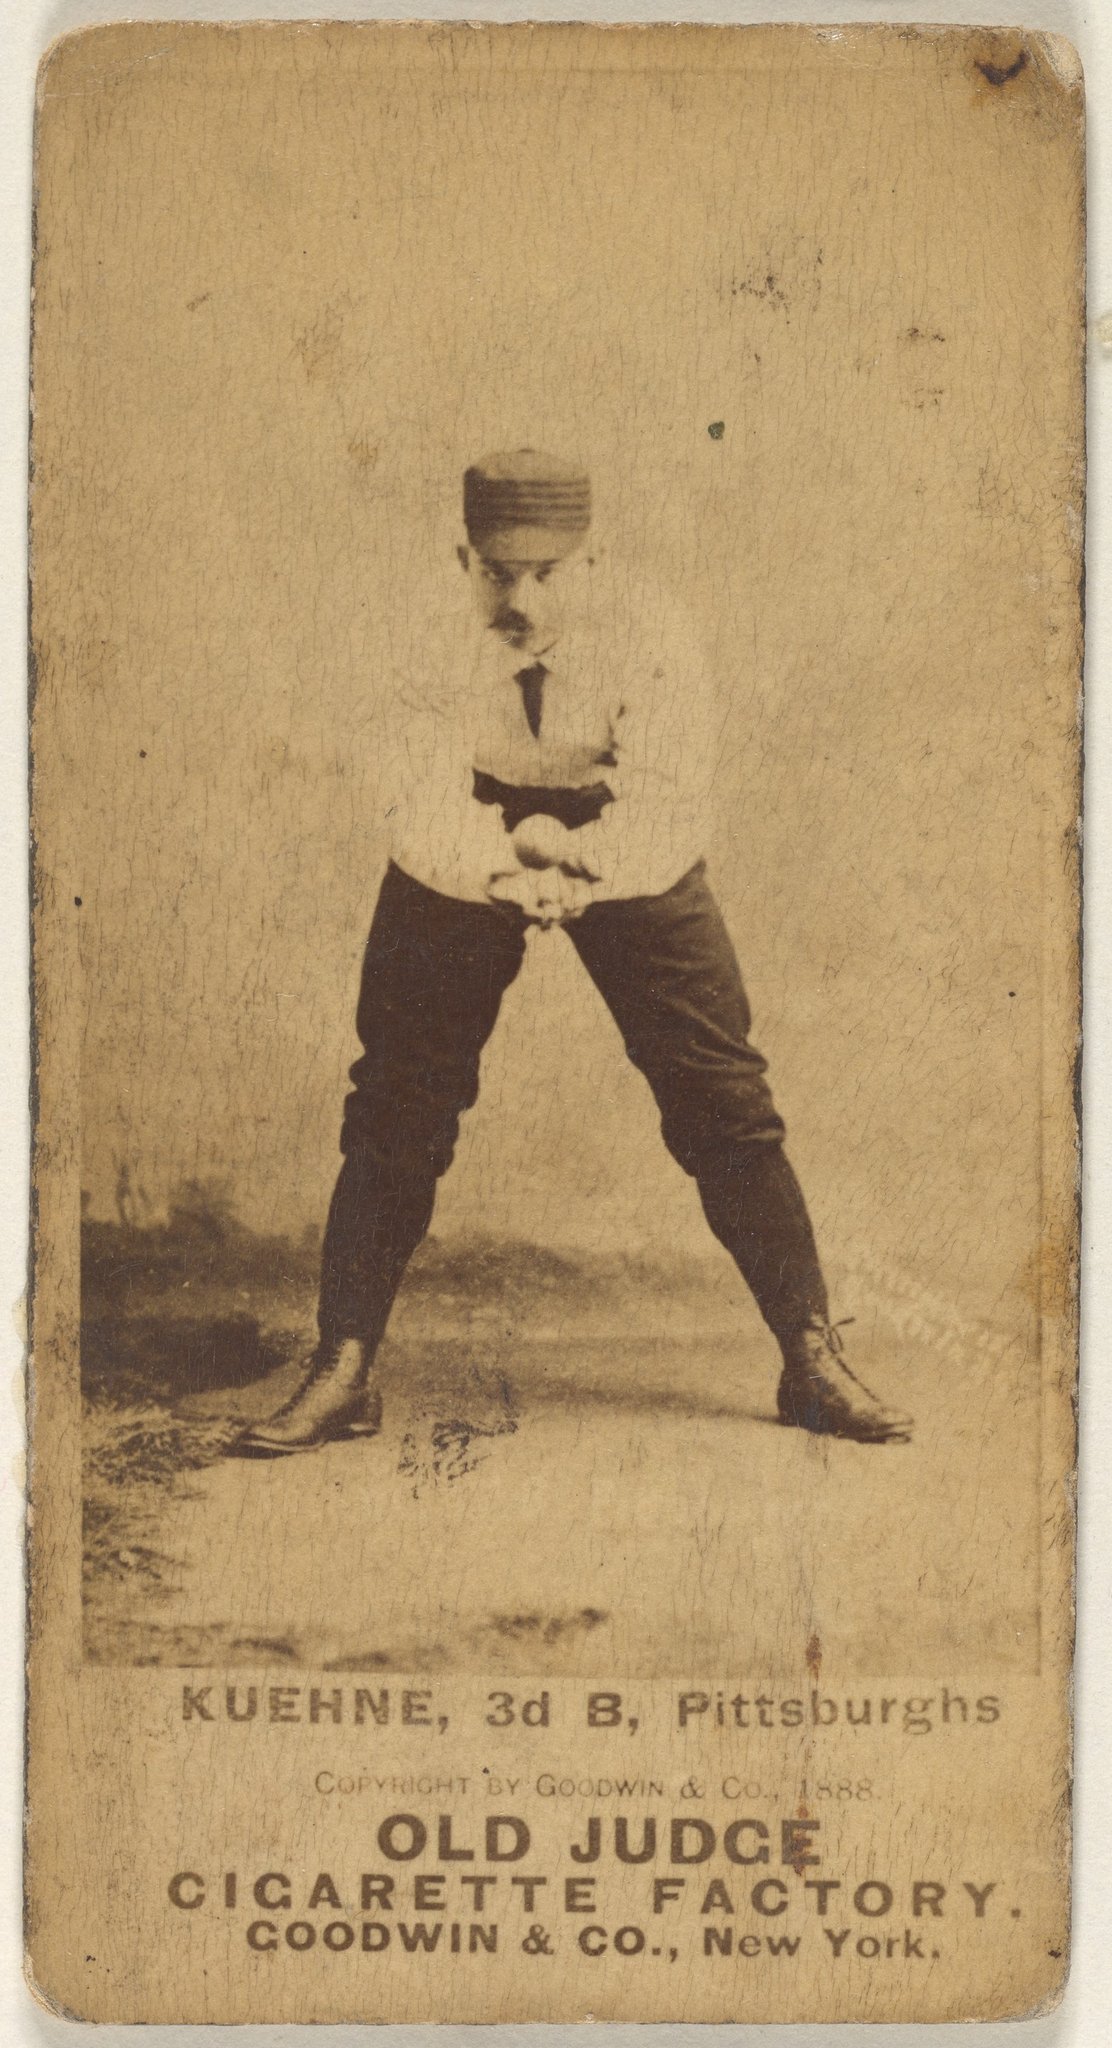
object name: baseball card, photograph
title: Bill Kuehne, 3rd Base, Pittsburgh, from the Old Judge series (N172) for Old Judge Cigarettes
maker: goodwin & company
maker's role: publisher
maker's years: 1850-1950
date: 1888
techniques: albumen silver print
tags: men,portraits,baseball,athletes